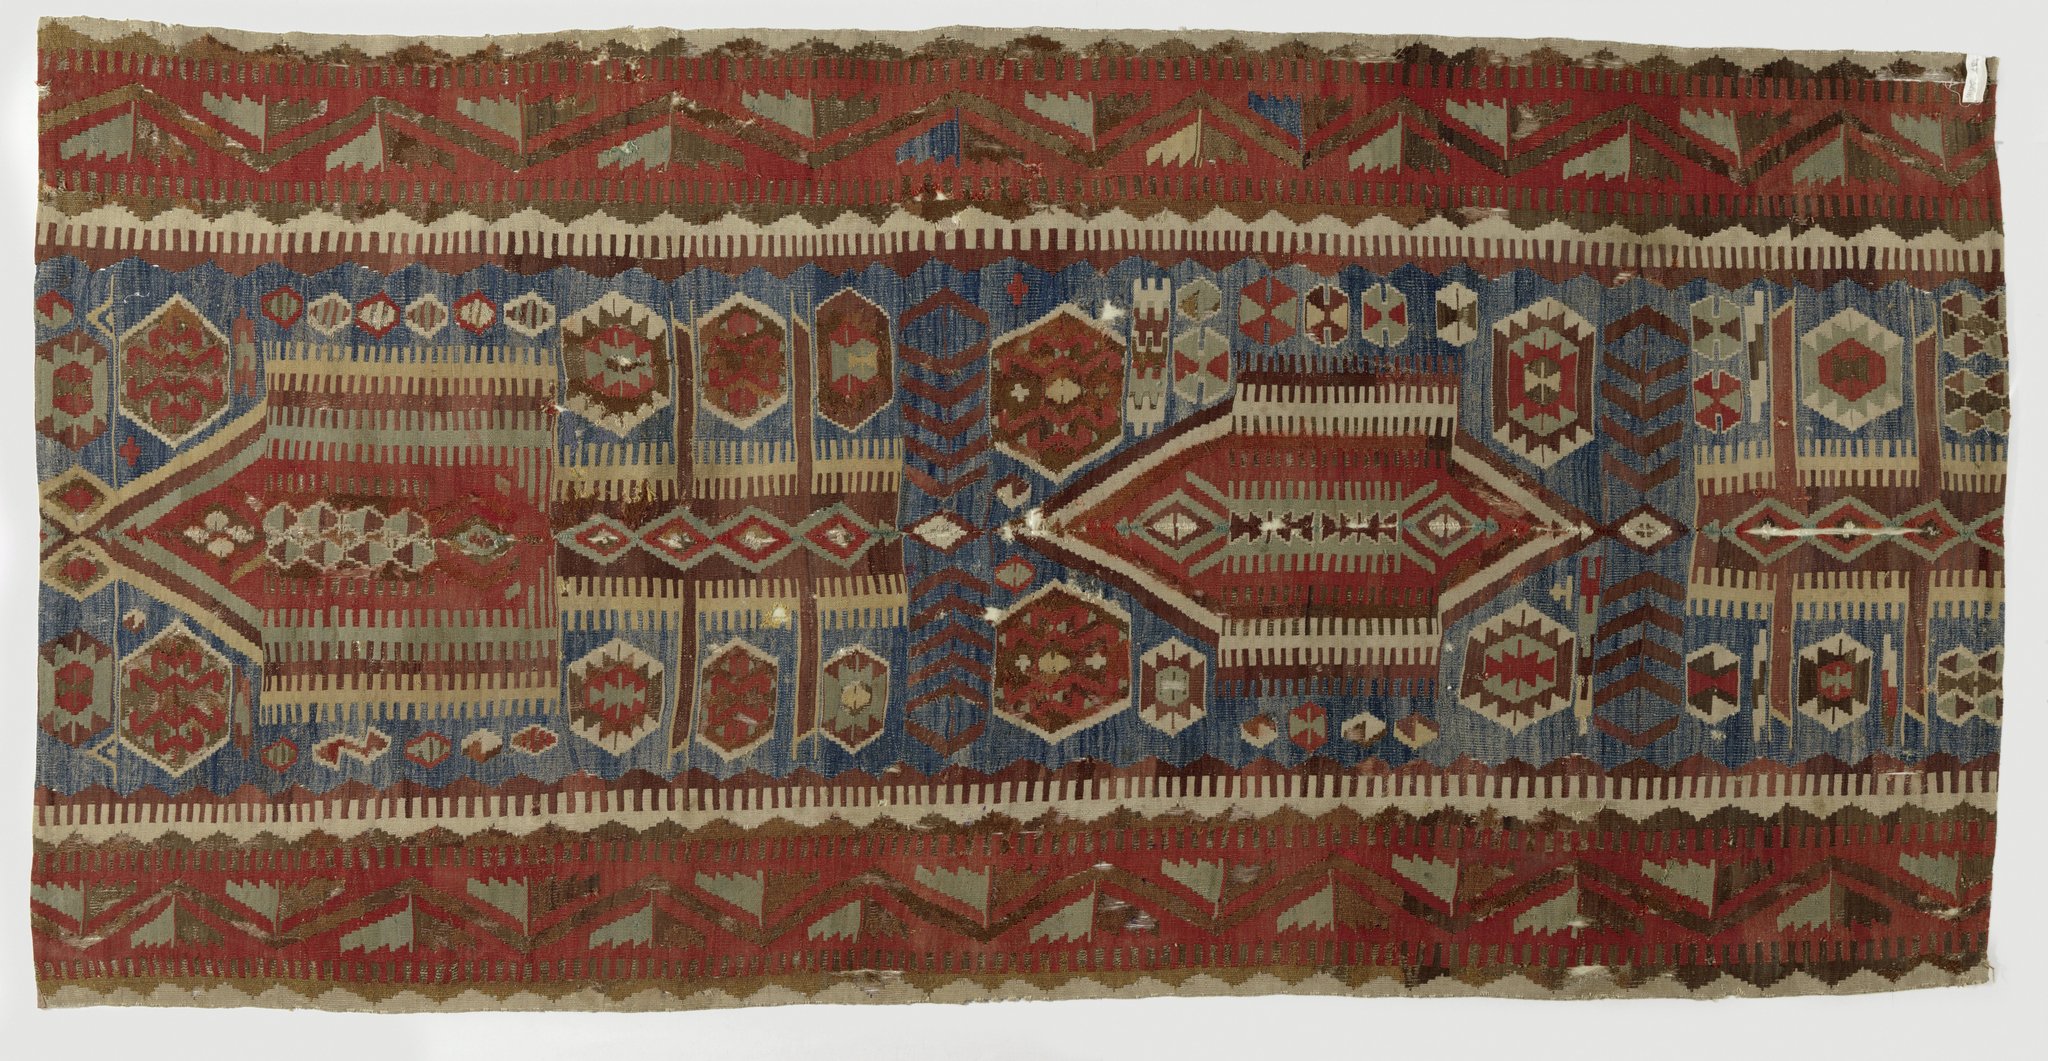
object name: prayer rug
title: Oosters tapijt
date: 1800-1860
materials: wool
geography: asia minor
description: Bidkleed in kelim-techniek. Op het middenveld drie rode mihrabs, de middelste dubbelzijdig. Op de middenas een baan met ruiten, geflankeerd door arceerlijnen en zeshoeken met diabolo sterren. Randen viervoudig, de breedste met een zigzaglijn die een dubbelblad omsluit.